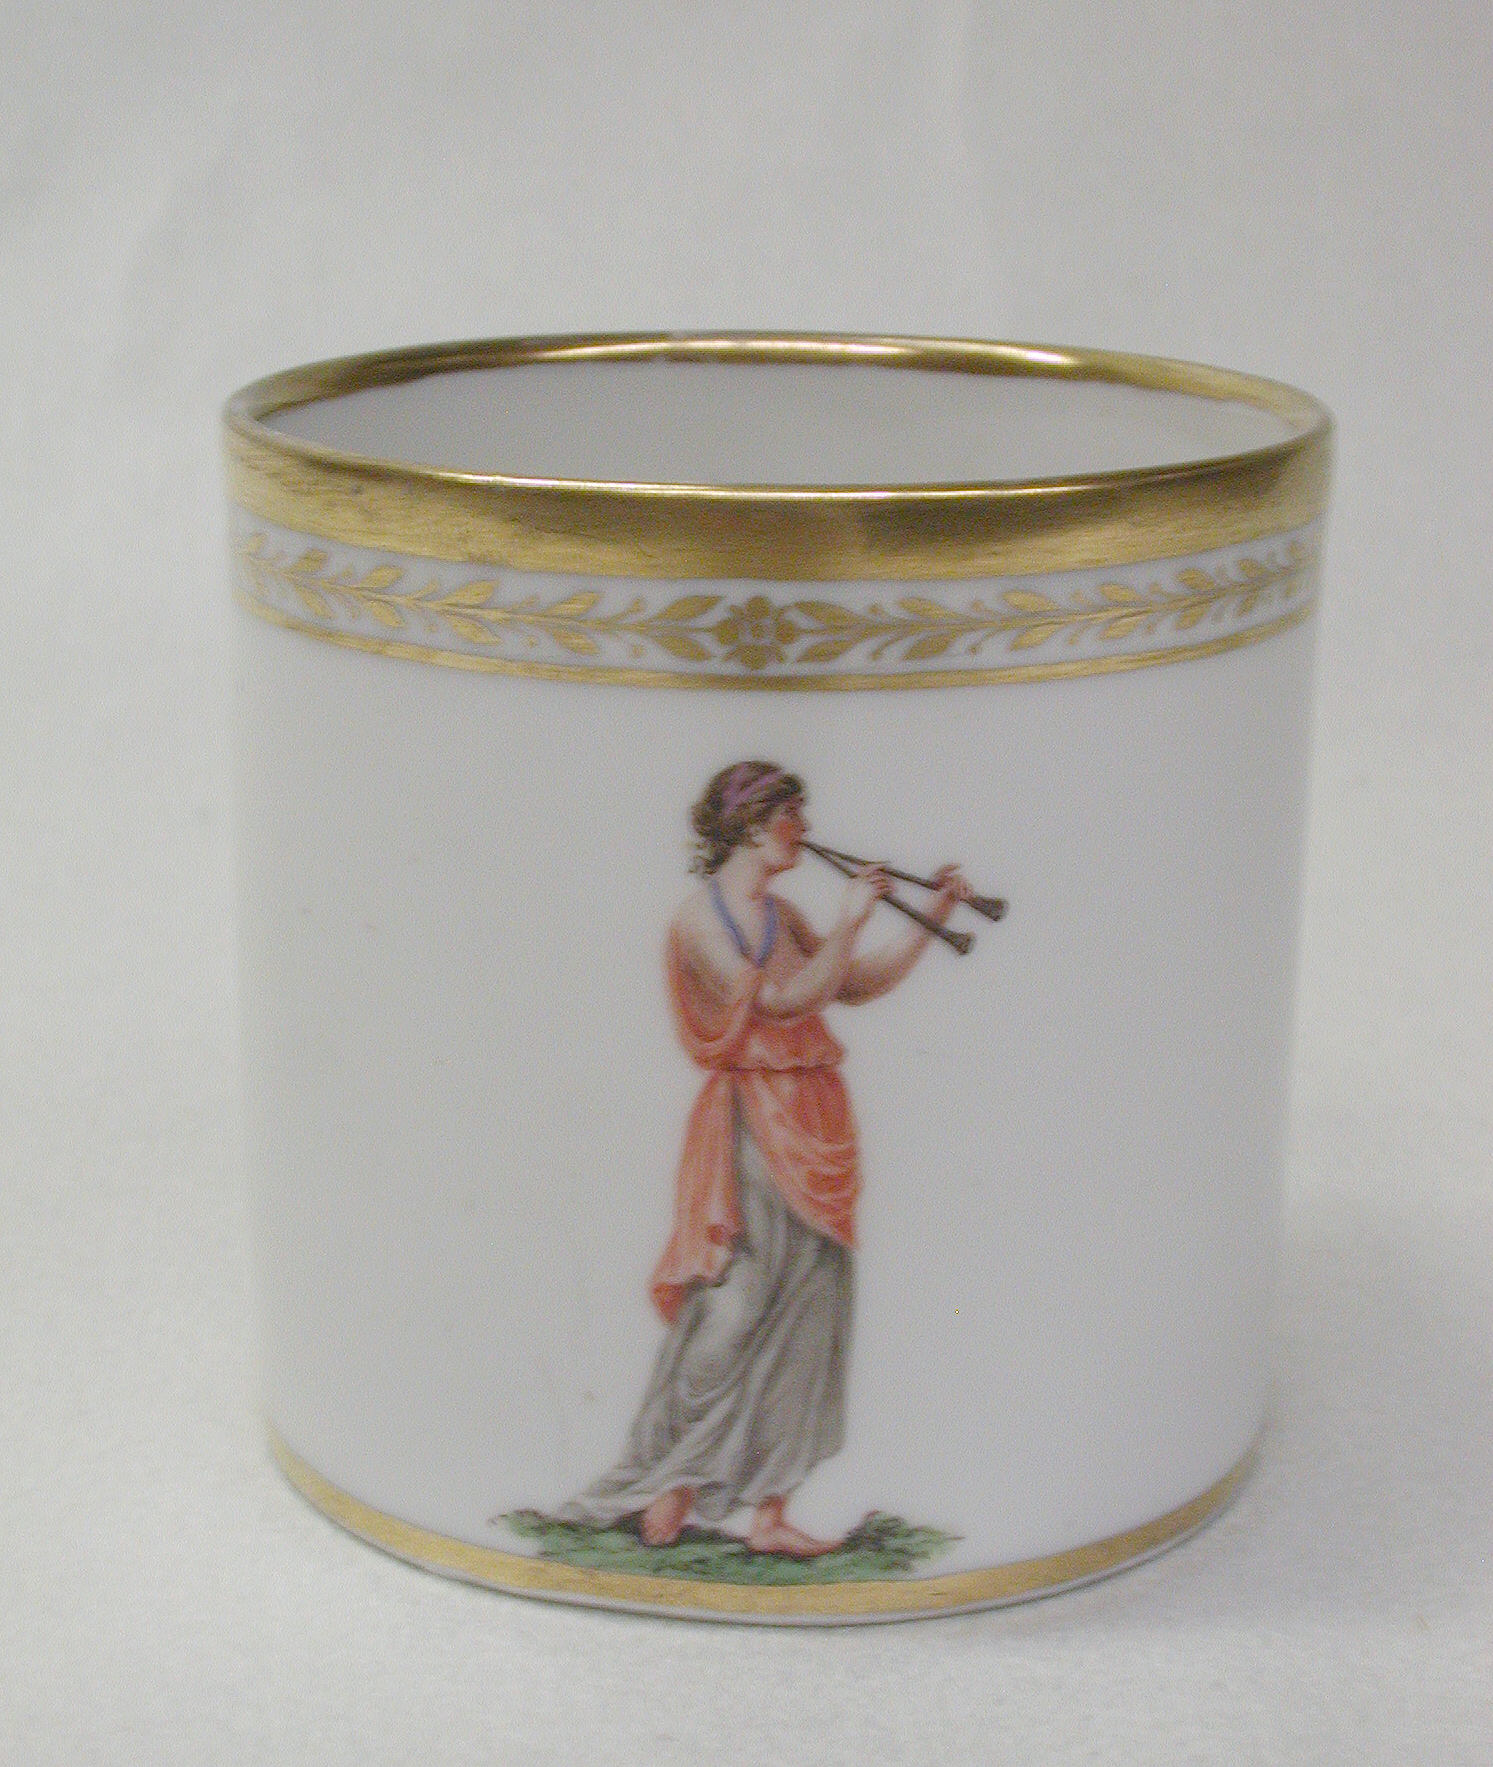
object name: cup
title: Cup (part of a coffee service)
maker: nymphenburg porcelain manufactory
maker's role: manufactory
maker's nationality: german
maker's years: 1747-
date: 1801-1833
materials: hard paste porcelain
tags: musical instruments,women